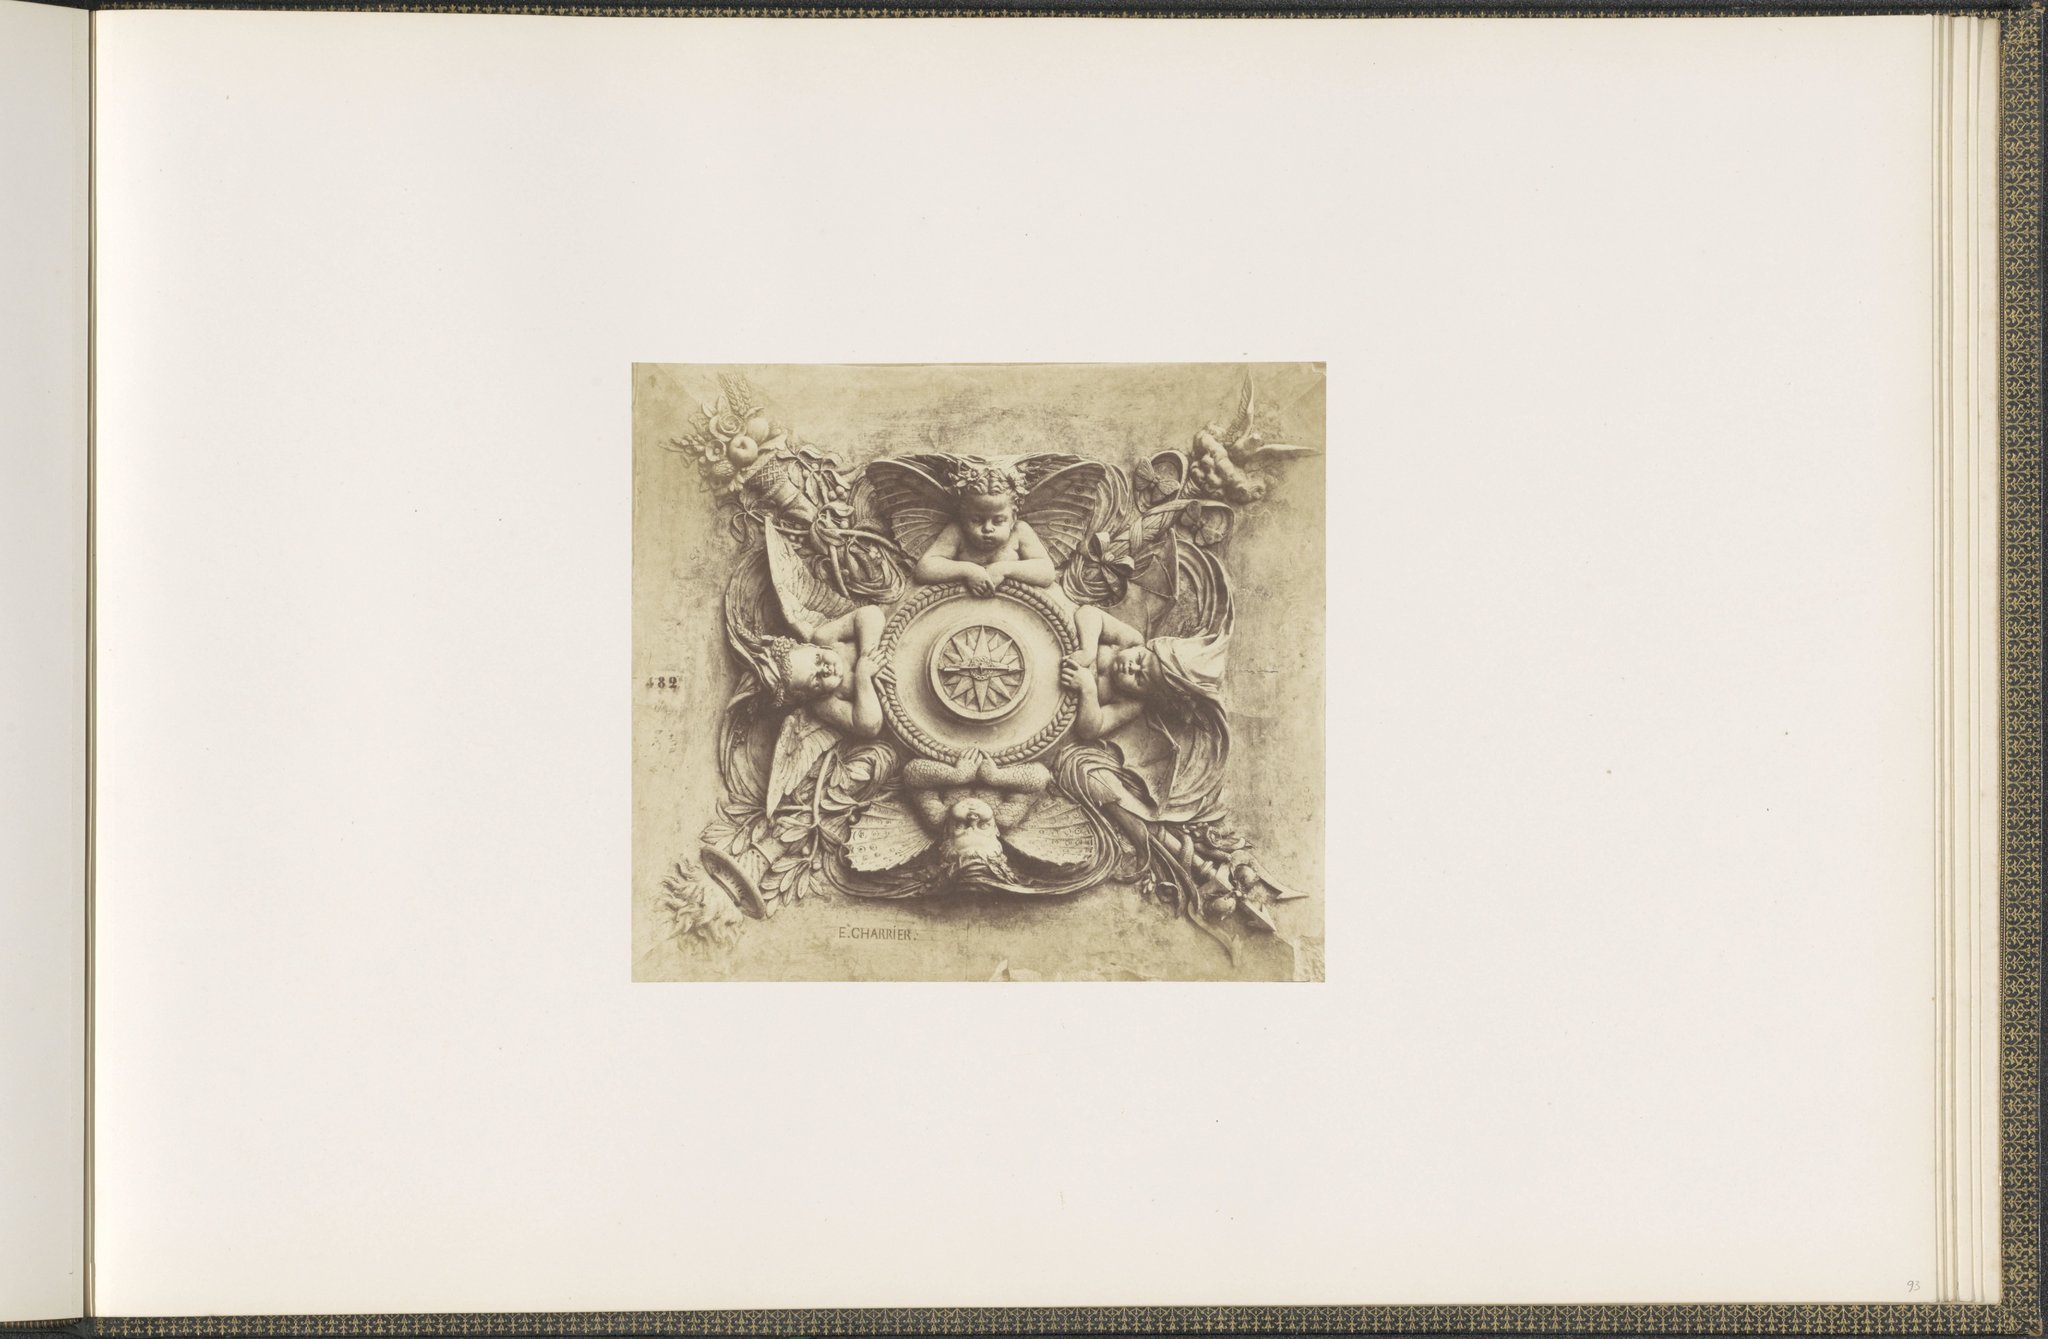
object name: photograph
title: Gipsmodel voor een gewelfversiering van het Palais du Louvre door Pierre Edouard Charrier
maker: édouard denis baldus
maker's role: fotograaf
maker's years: 1813-1889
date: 1855-1857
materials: paper, photographic support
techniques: salted paper print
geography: paris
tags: permanent exhibition, museum, ornamenting, decorating ~ applied arts, paris, tuileries palace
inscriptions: number: ‘482’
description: Onderdeel van Réunion des Tuileries au Louvre 1852-1857, album 4.